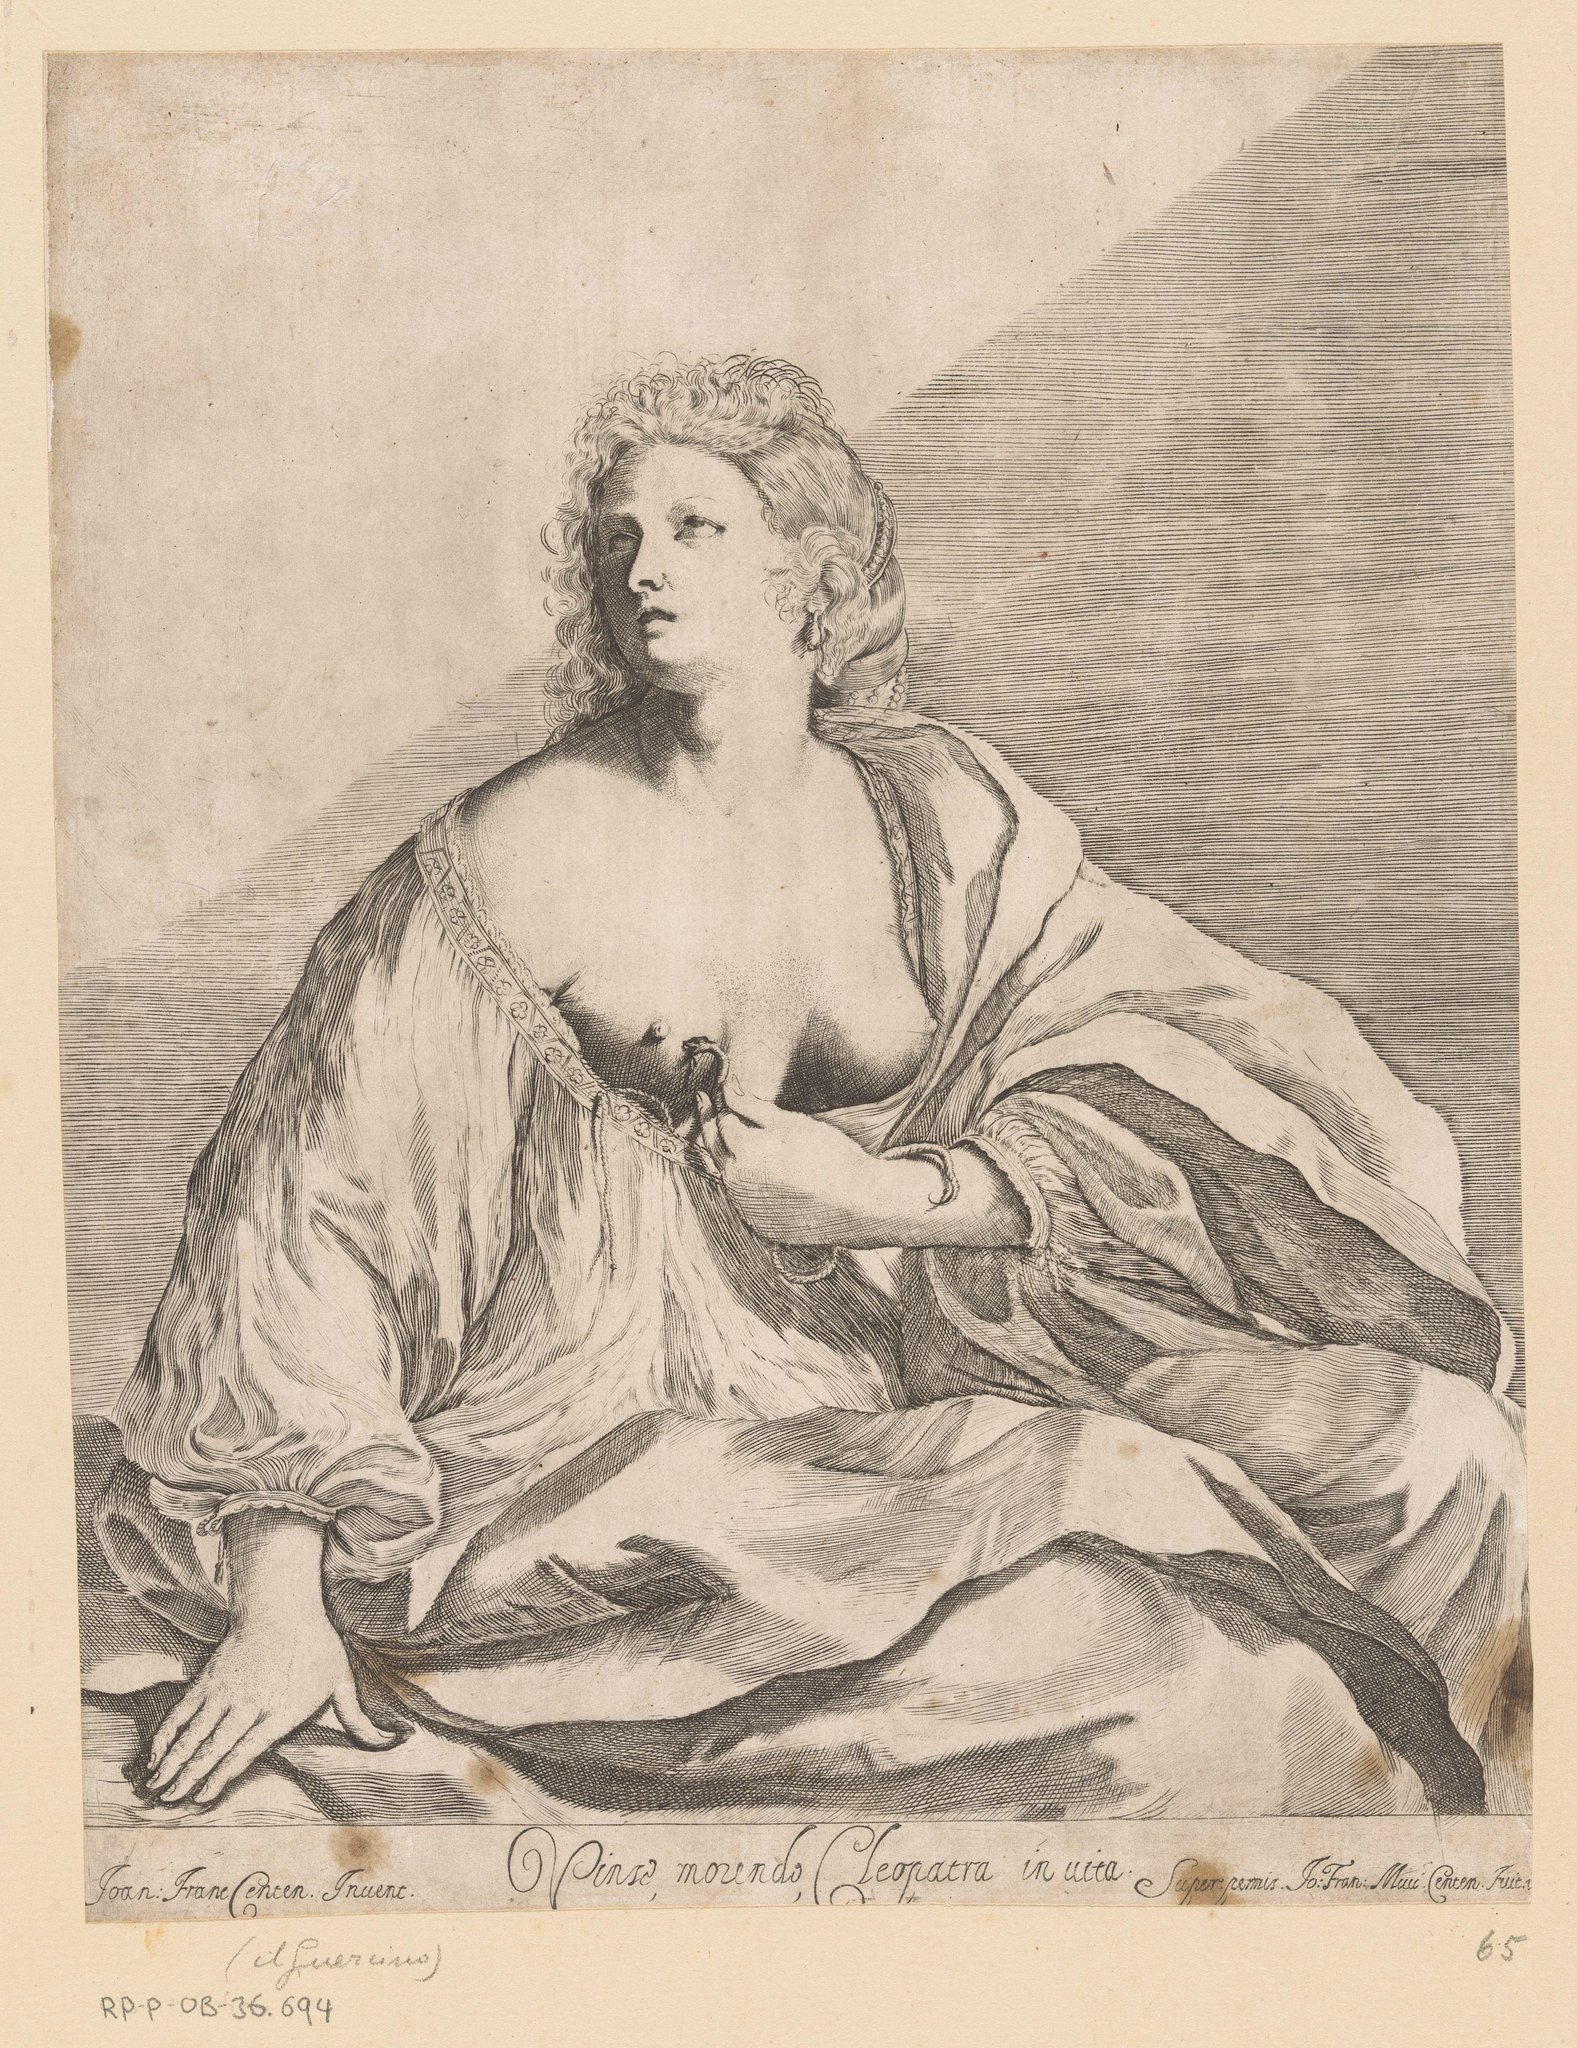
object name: print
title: Dood van Cleopatra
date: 1530-1565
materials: paper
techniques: engraving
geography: italy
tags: death of cleopatra: she commits suicide by holding to her breast an asp, which she has taken from a basket of figs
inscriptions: collector's mark: Lugt 240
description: Cleopatra, koningin van Egypte, maakt een eind aan haar leven door zich te laten bijten door een giftige slang. Ze zit met in haar linkerhand de in haar borst bijtende slang, haar blik omhoog gericht.